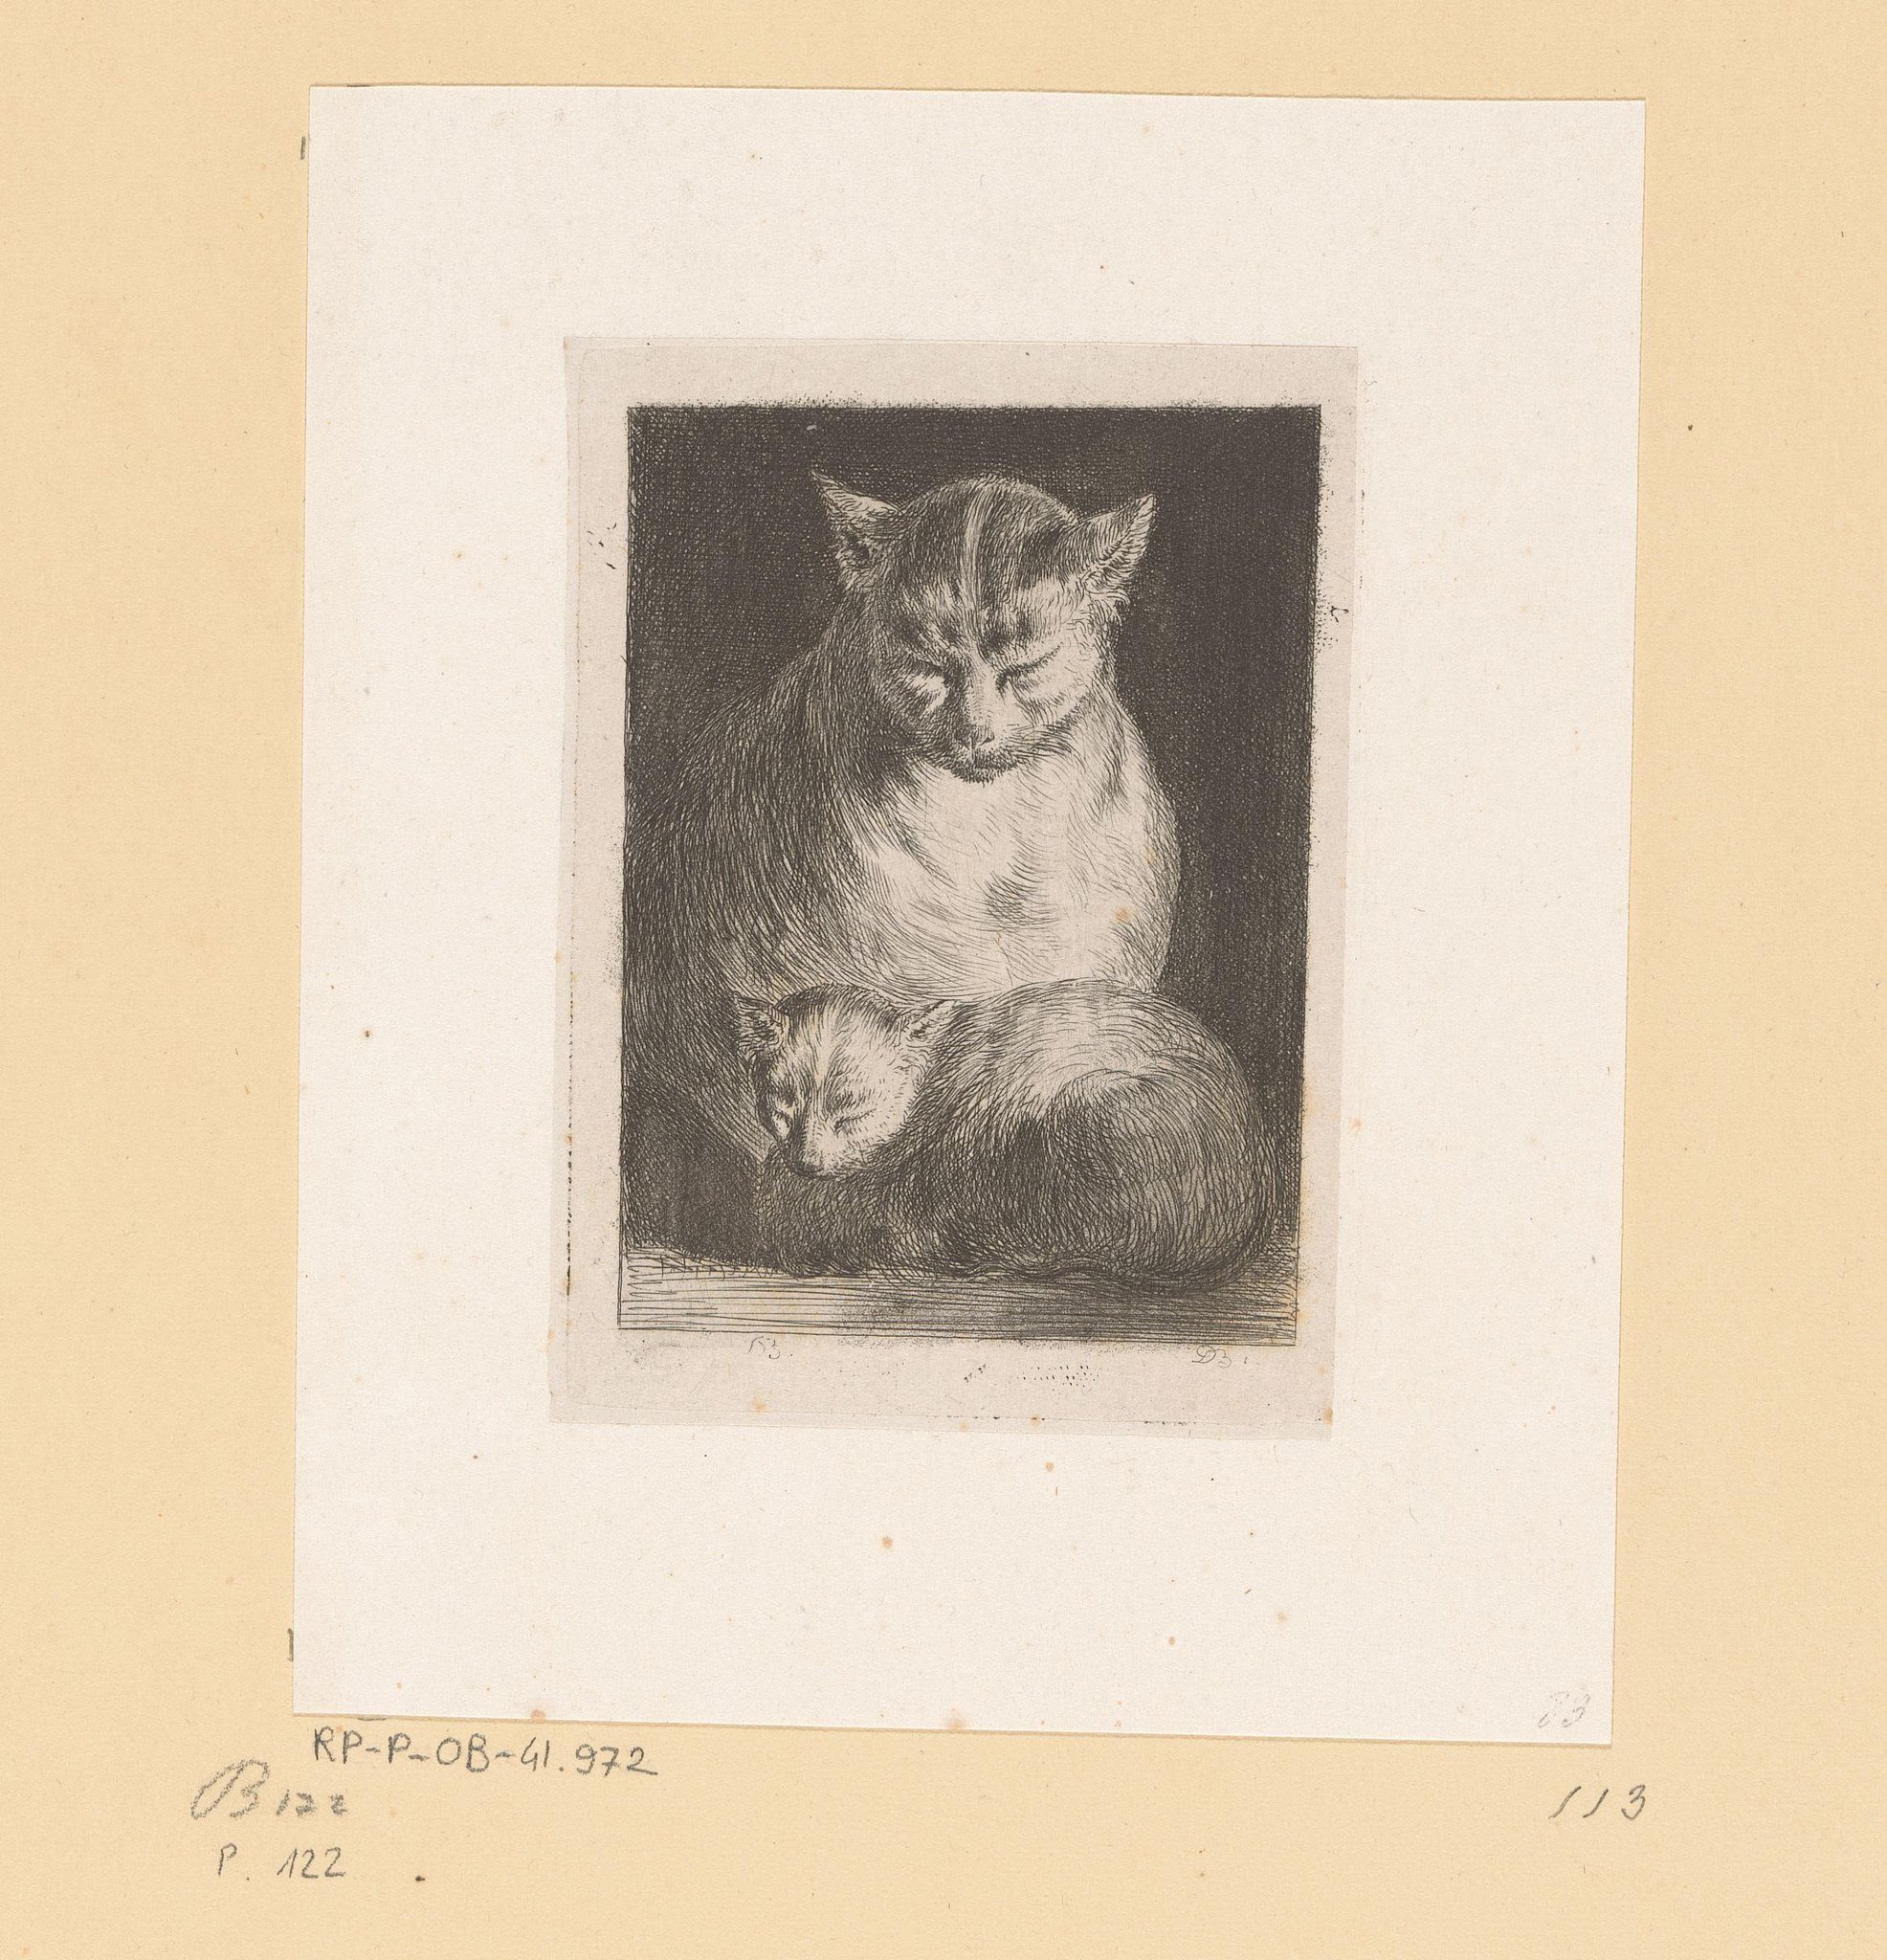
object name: print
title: Kat met haar jong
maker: jean jacques de boissieu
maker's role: draughtsman, print maker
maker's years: 1736-1810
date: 1803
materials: paper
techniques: drypoint, etching, roulette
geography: france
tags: cat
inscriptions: collector's mark: Lugt 12